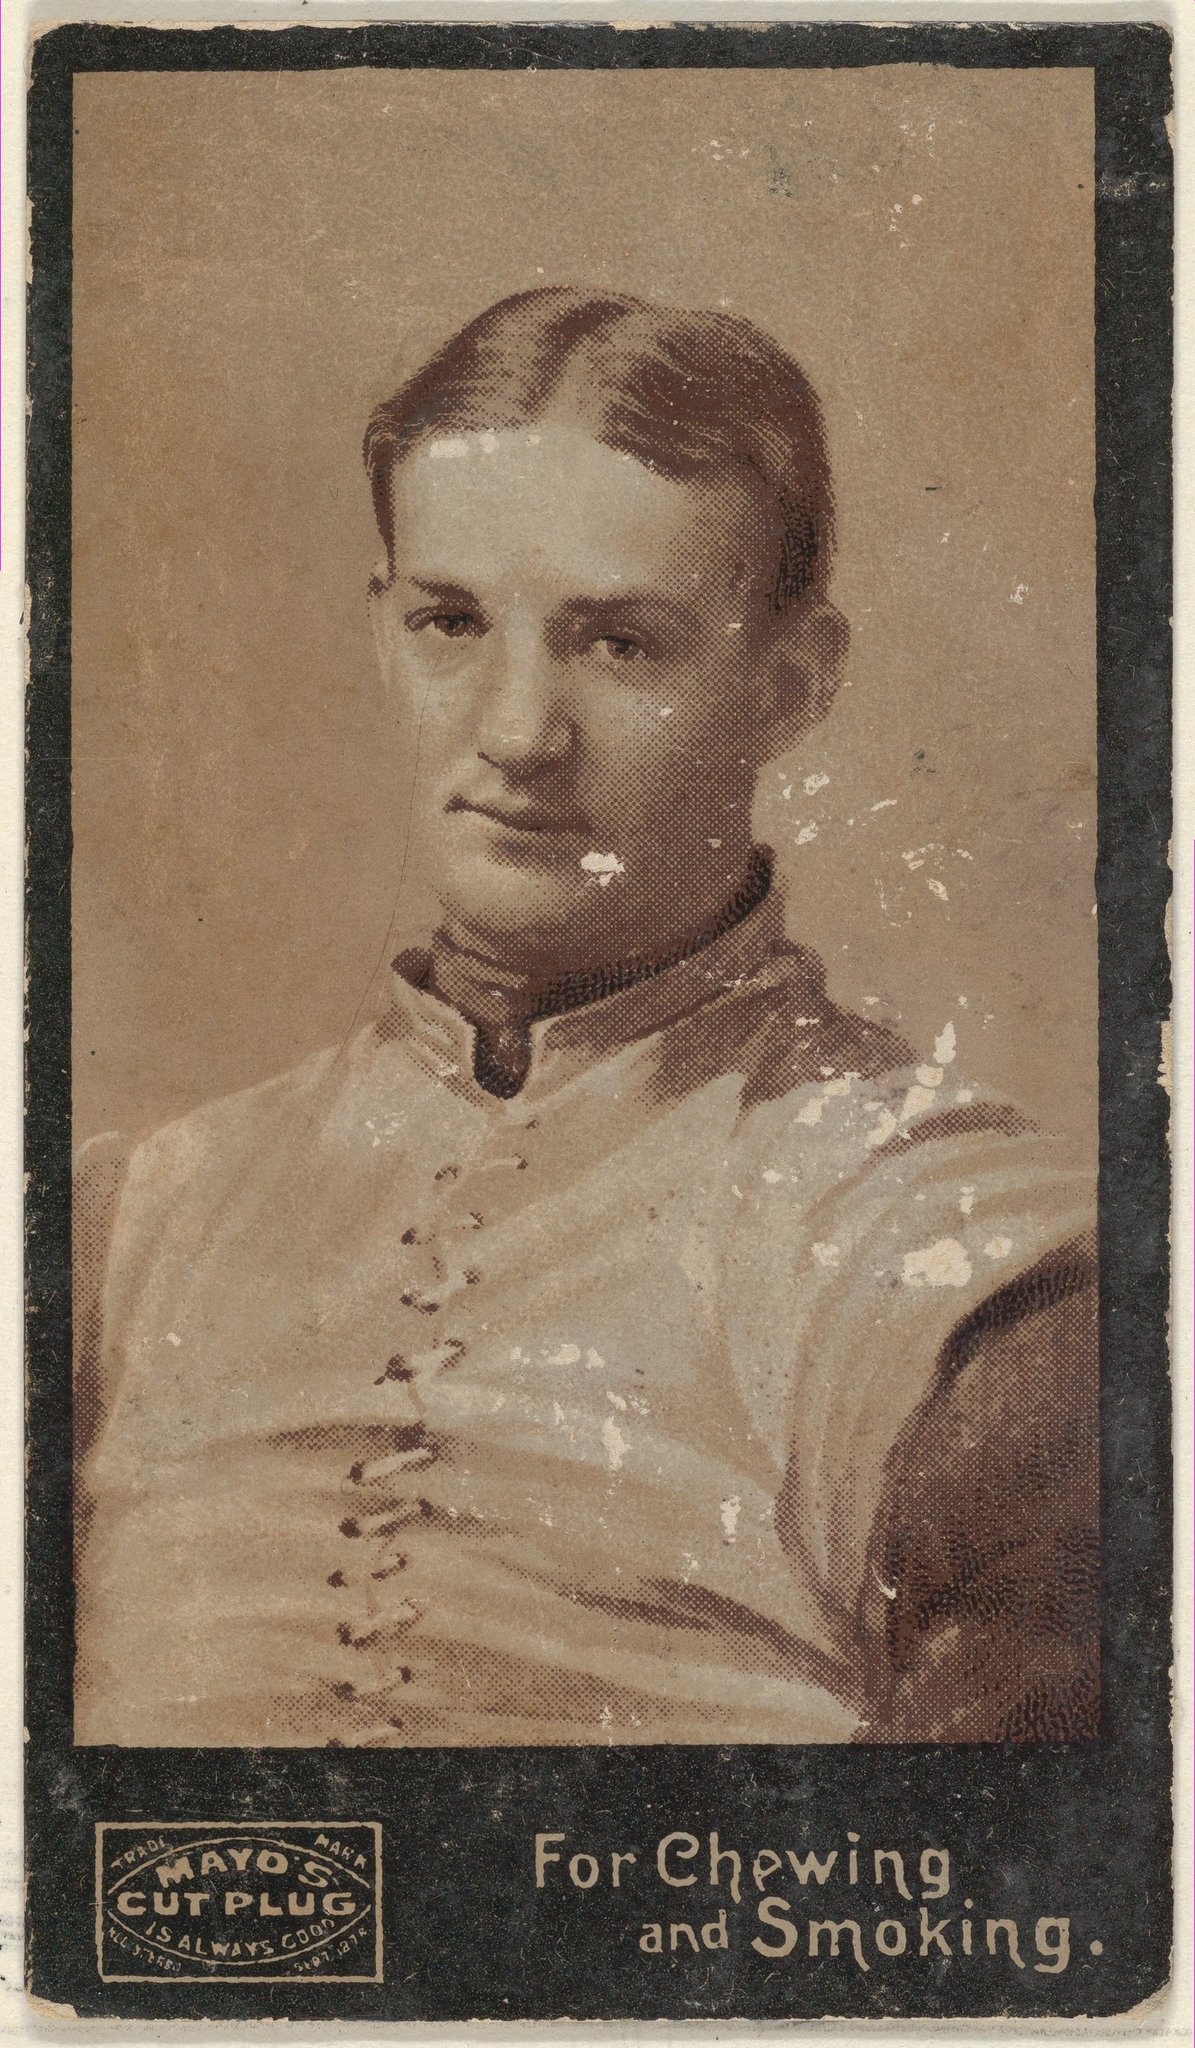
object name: print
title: John Dunlop, Harvard University, from the College Football Stars series (N302) for Mayo's Cut Plug Tobacco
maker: p.h. mayo & brother, richmond, virginia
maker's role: publisher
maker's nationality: american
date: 1894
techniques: lithography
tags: men,portraits,football,athletes